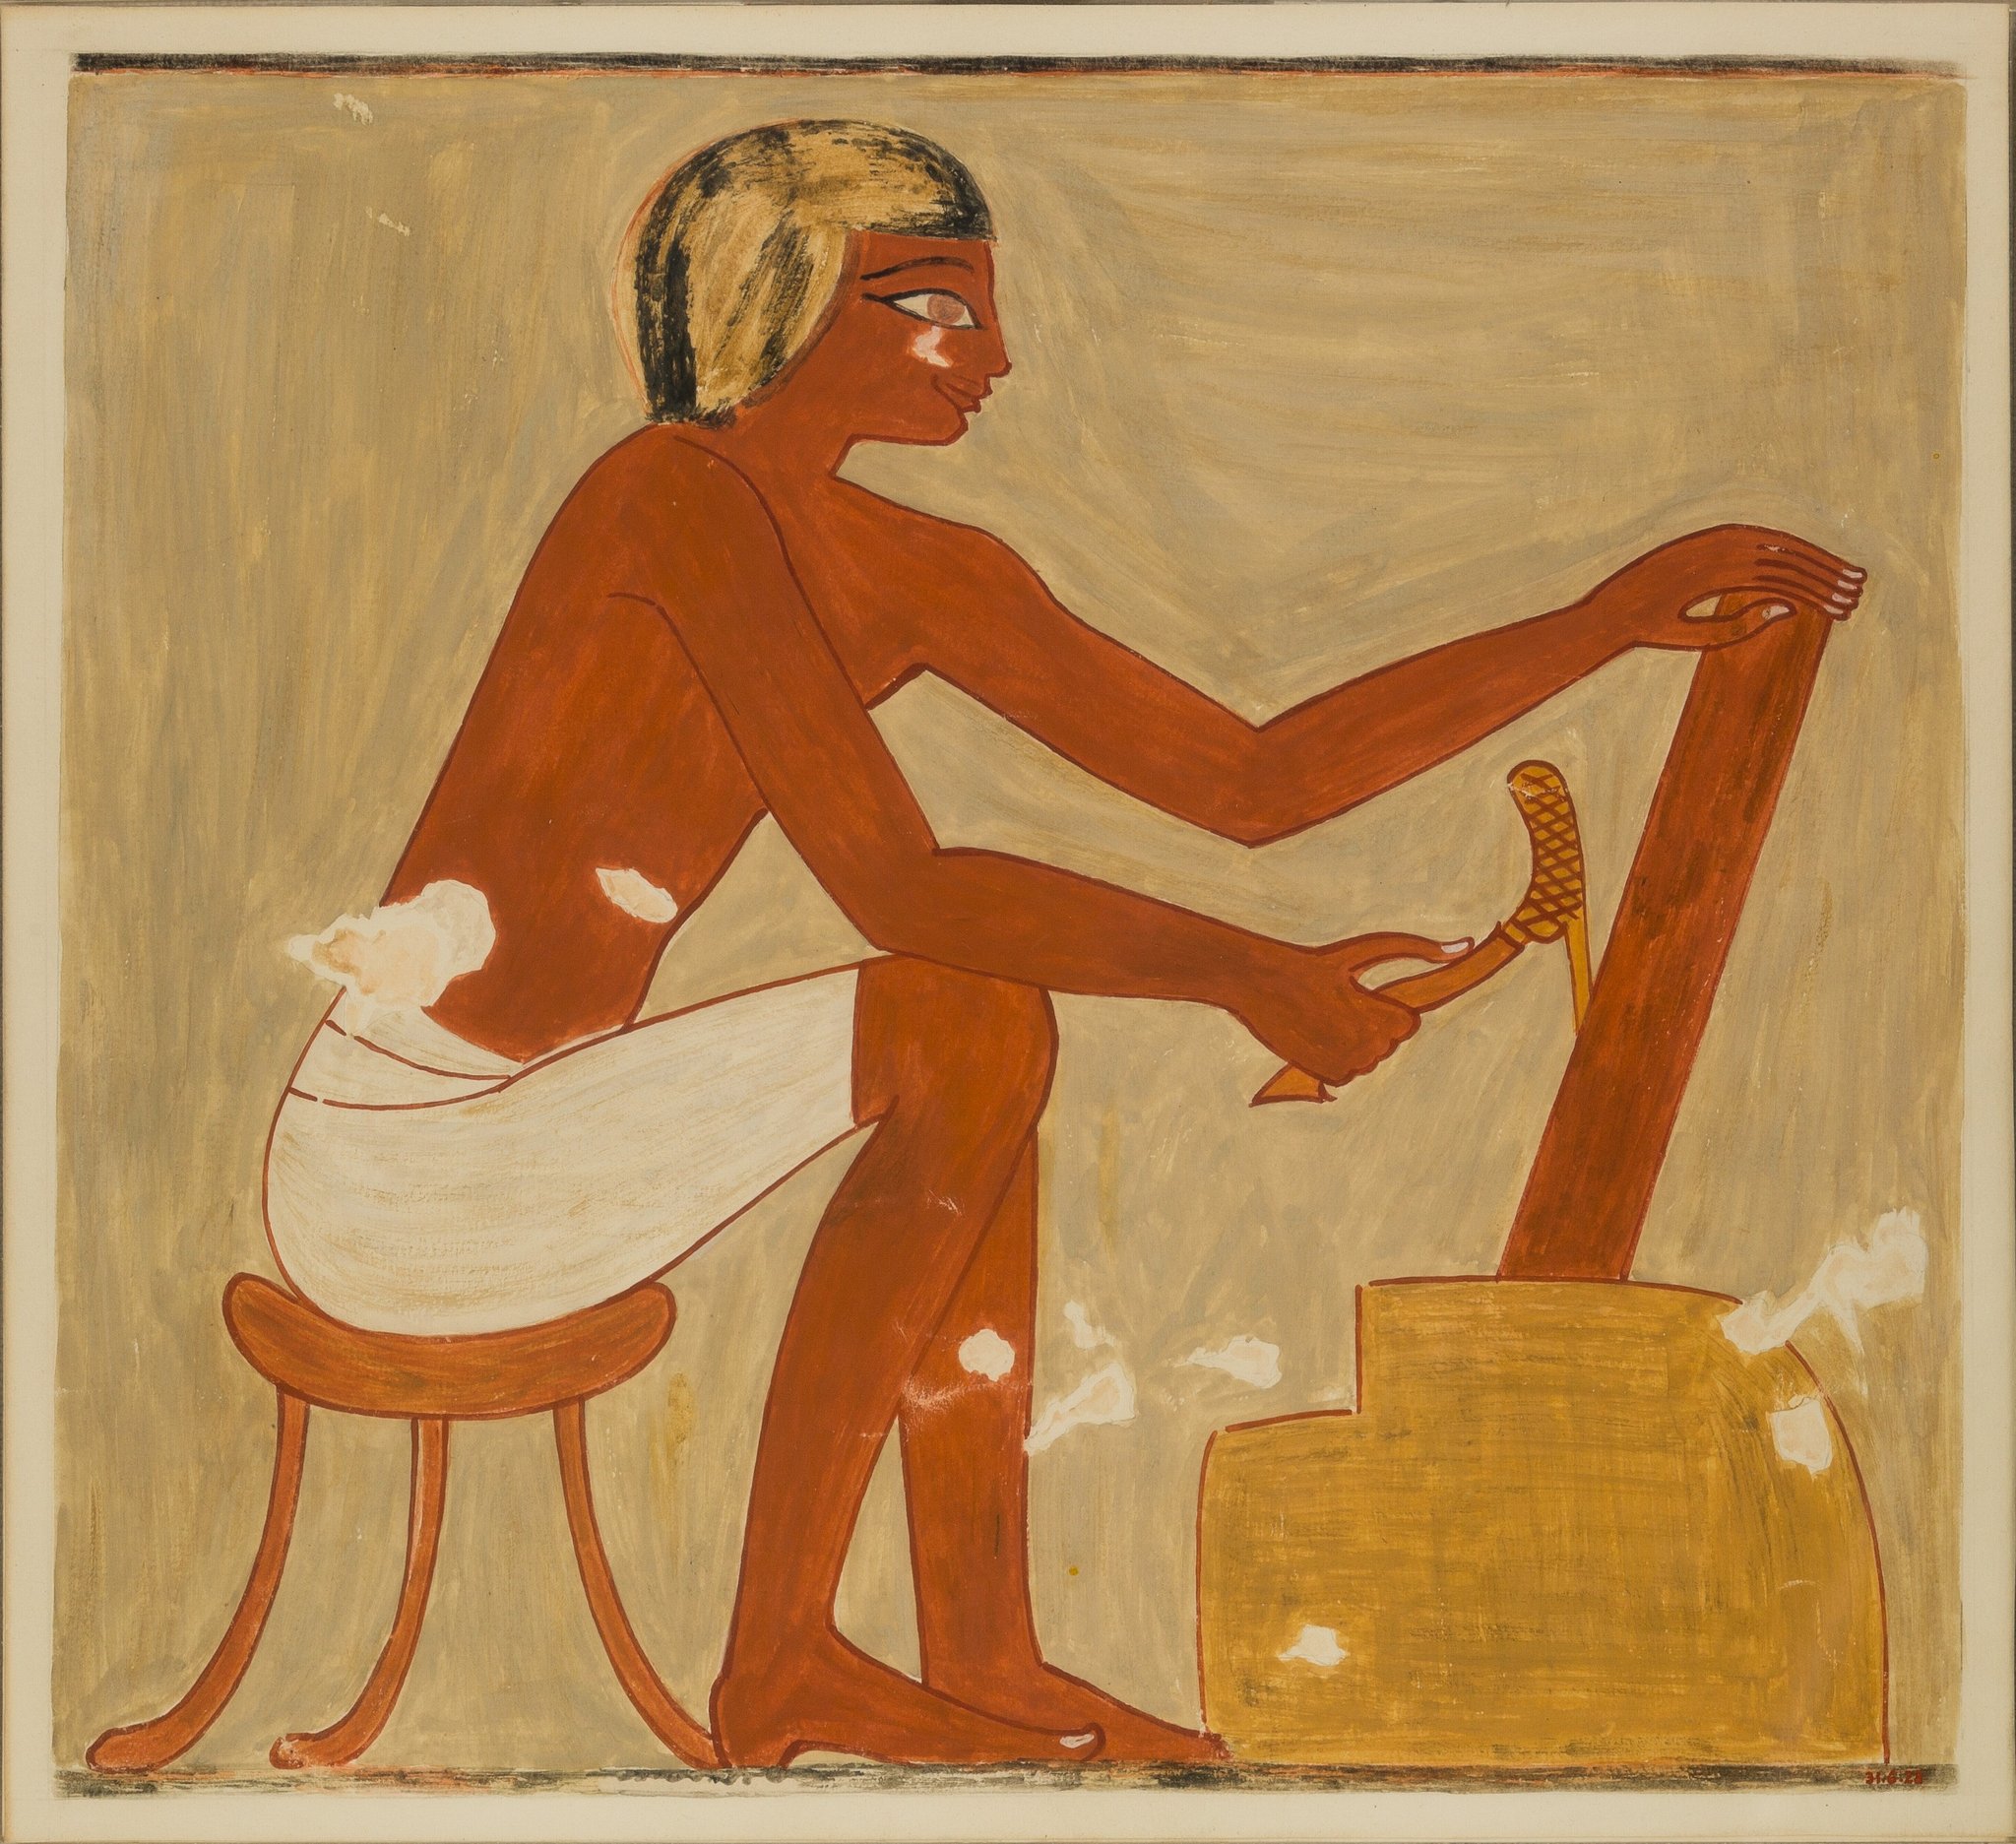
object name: facsimile, rekhmire tt 100, carpenter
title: Trimming Wood with an Adze, Tomb of Rekhmire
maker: nina de garis davies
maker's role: artist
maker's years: 1881-1965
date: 1504-1425 BCE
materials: ink, paint, paper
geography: egypt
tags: men,working,tools,rekhmire-exhibition